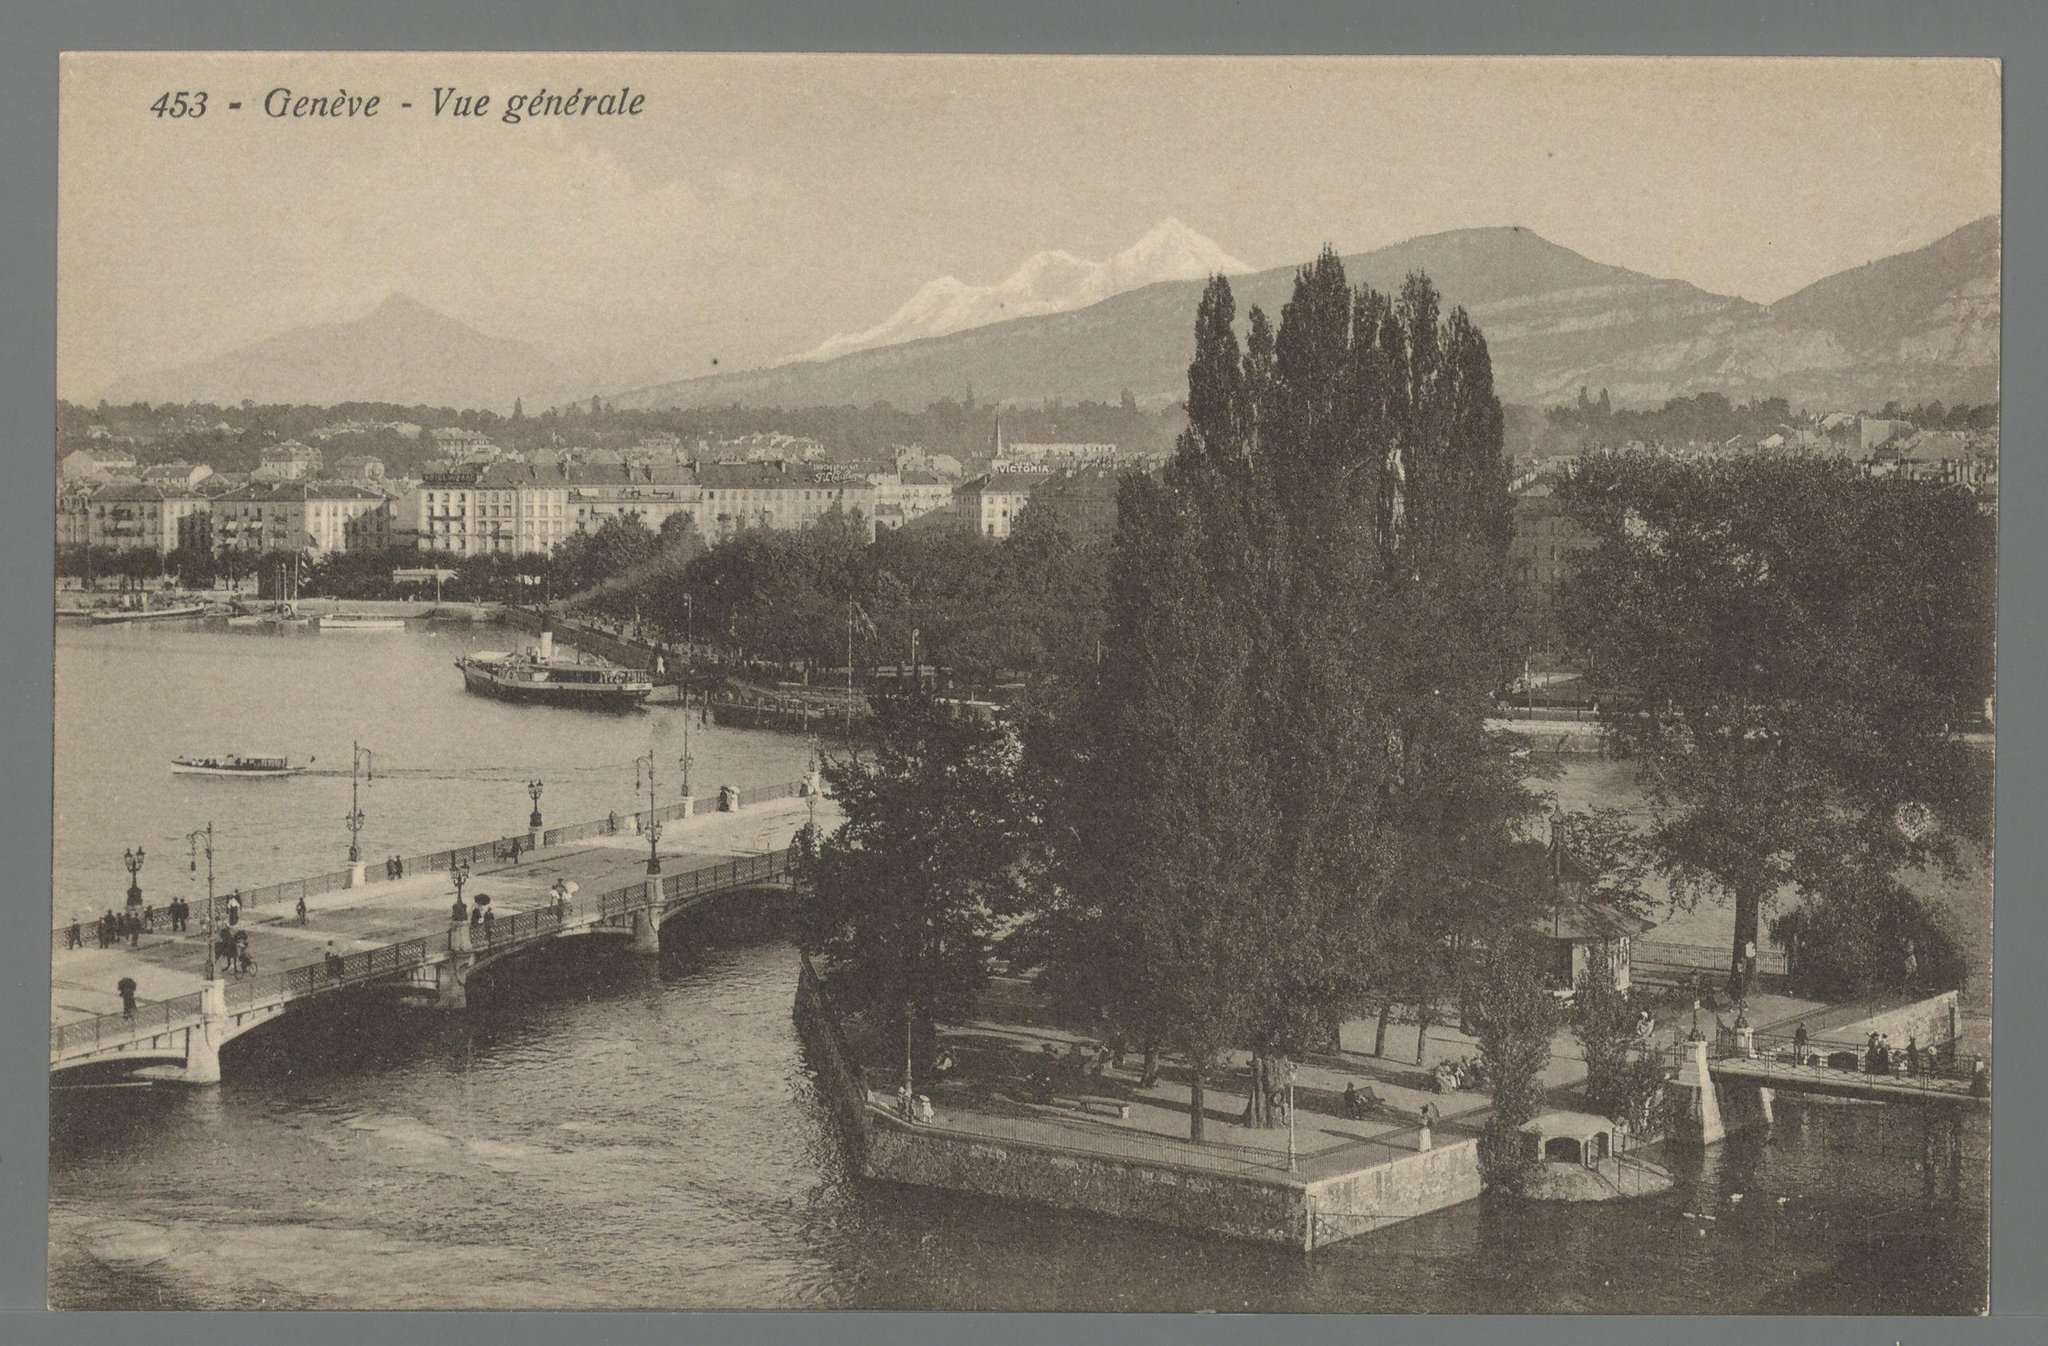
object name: photomechanical print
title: Genève. Vue générale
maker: Anonymous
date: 1905-1909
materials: cardboard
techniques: photograph, writing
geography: geneva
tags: lake, mountain-range, snow peaks, prospect of city, town panorama, silhouette of city (+ city(-scape) with figures, staffage)